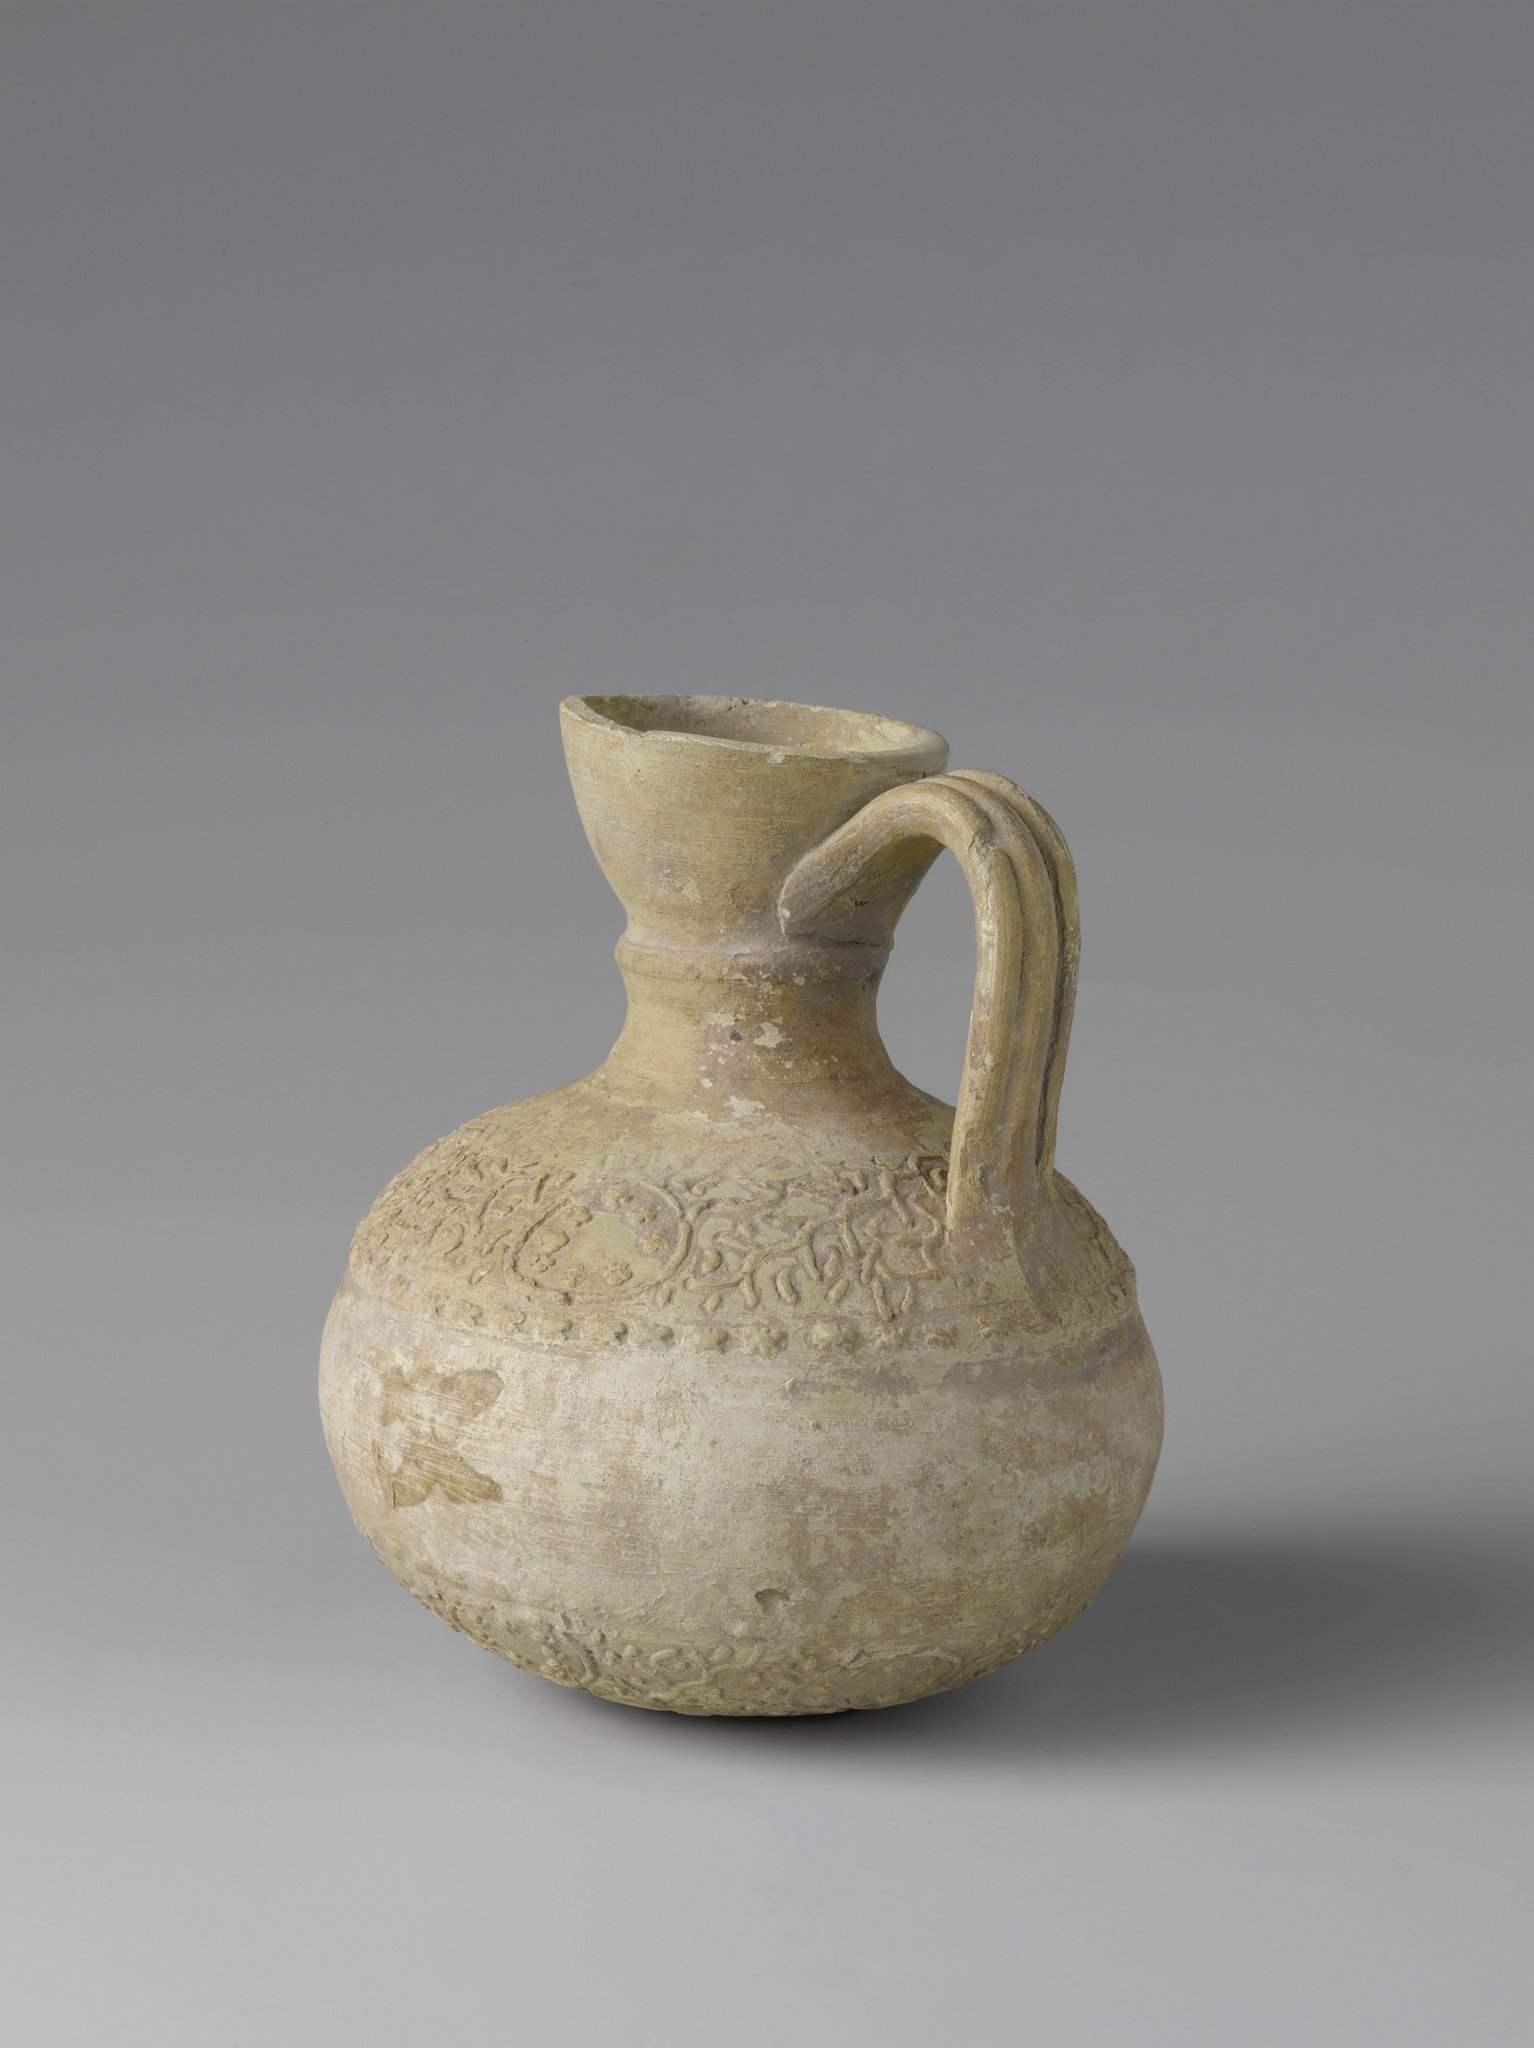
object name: jug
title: Vessel or pitcher with floral scrolls in relief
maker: Anonymous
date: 900-1399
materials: earthenware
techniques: firing, forming, relief, turning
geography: iran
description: Kruik van aardewerk met een bolvormig lichaam en een oor, gedecoreerd met bloemranken en medaillons met stippen in reliëf zonder glazuur.